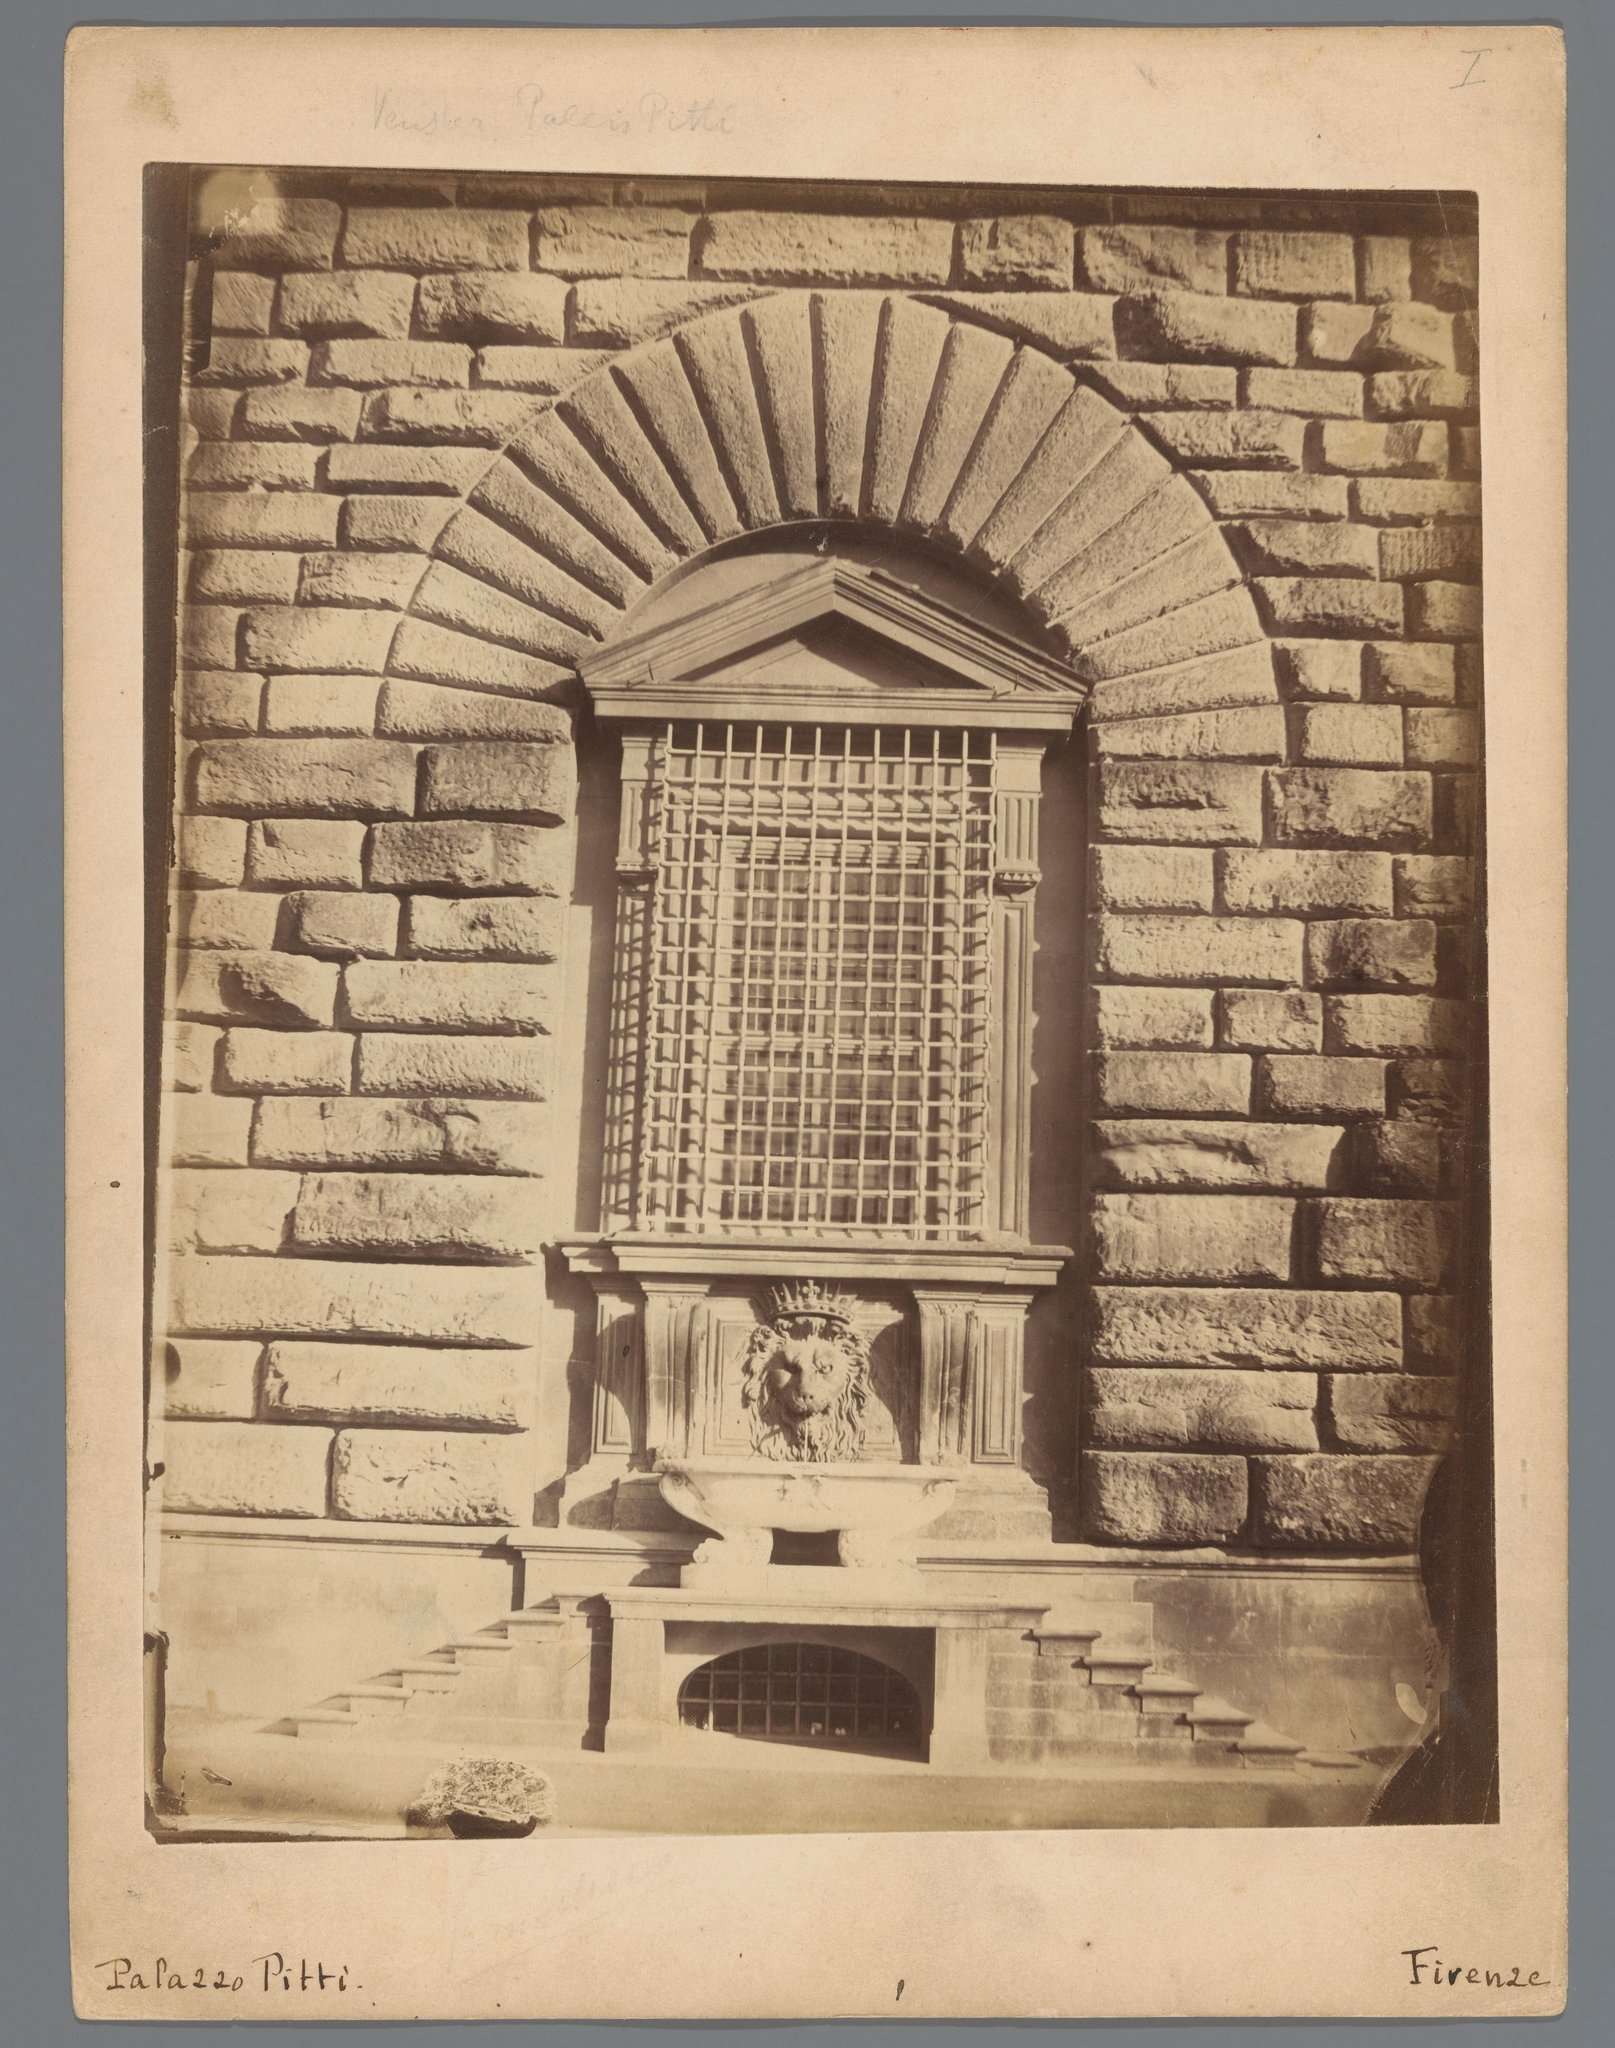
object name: photograph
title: Venster van Palazzo Pitti te Florence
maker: Anonymous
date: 1875-1900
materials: cardboard, photographic support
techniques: albumen print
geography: florence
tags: lion's head ~ ornament, window, palace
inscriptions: inscription: ‘Venster Paleis Pitti’, collector's mark: Lugt 3937